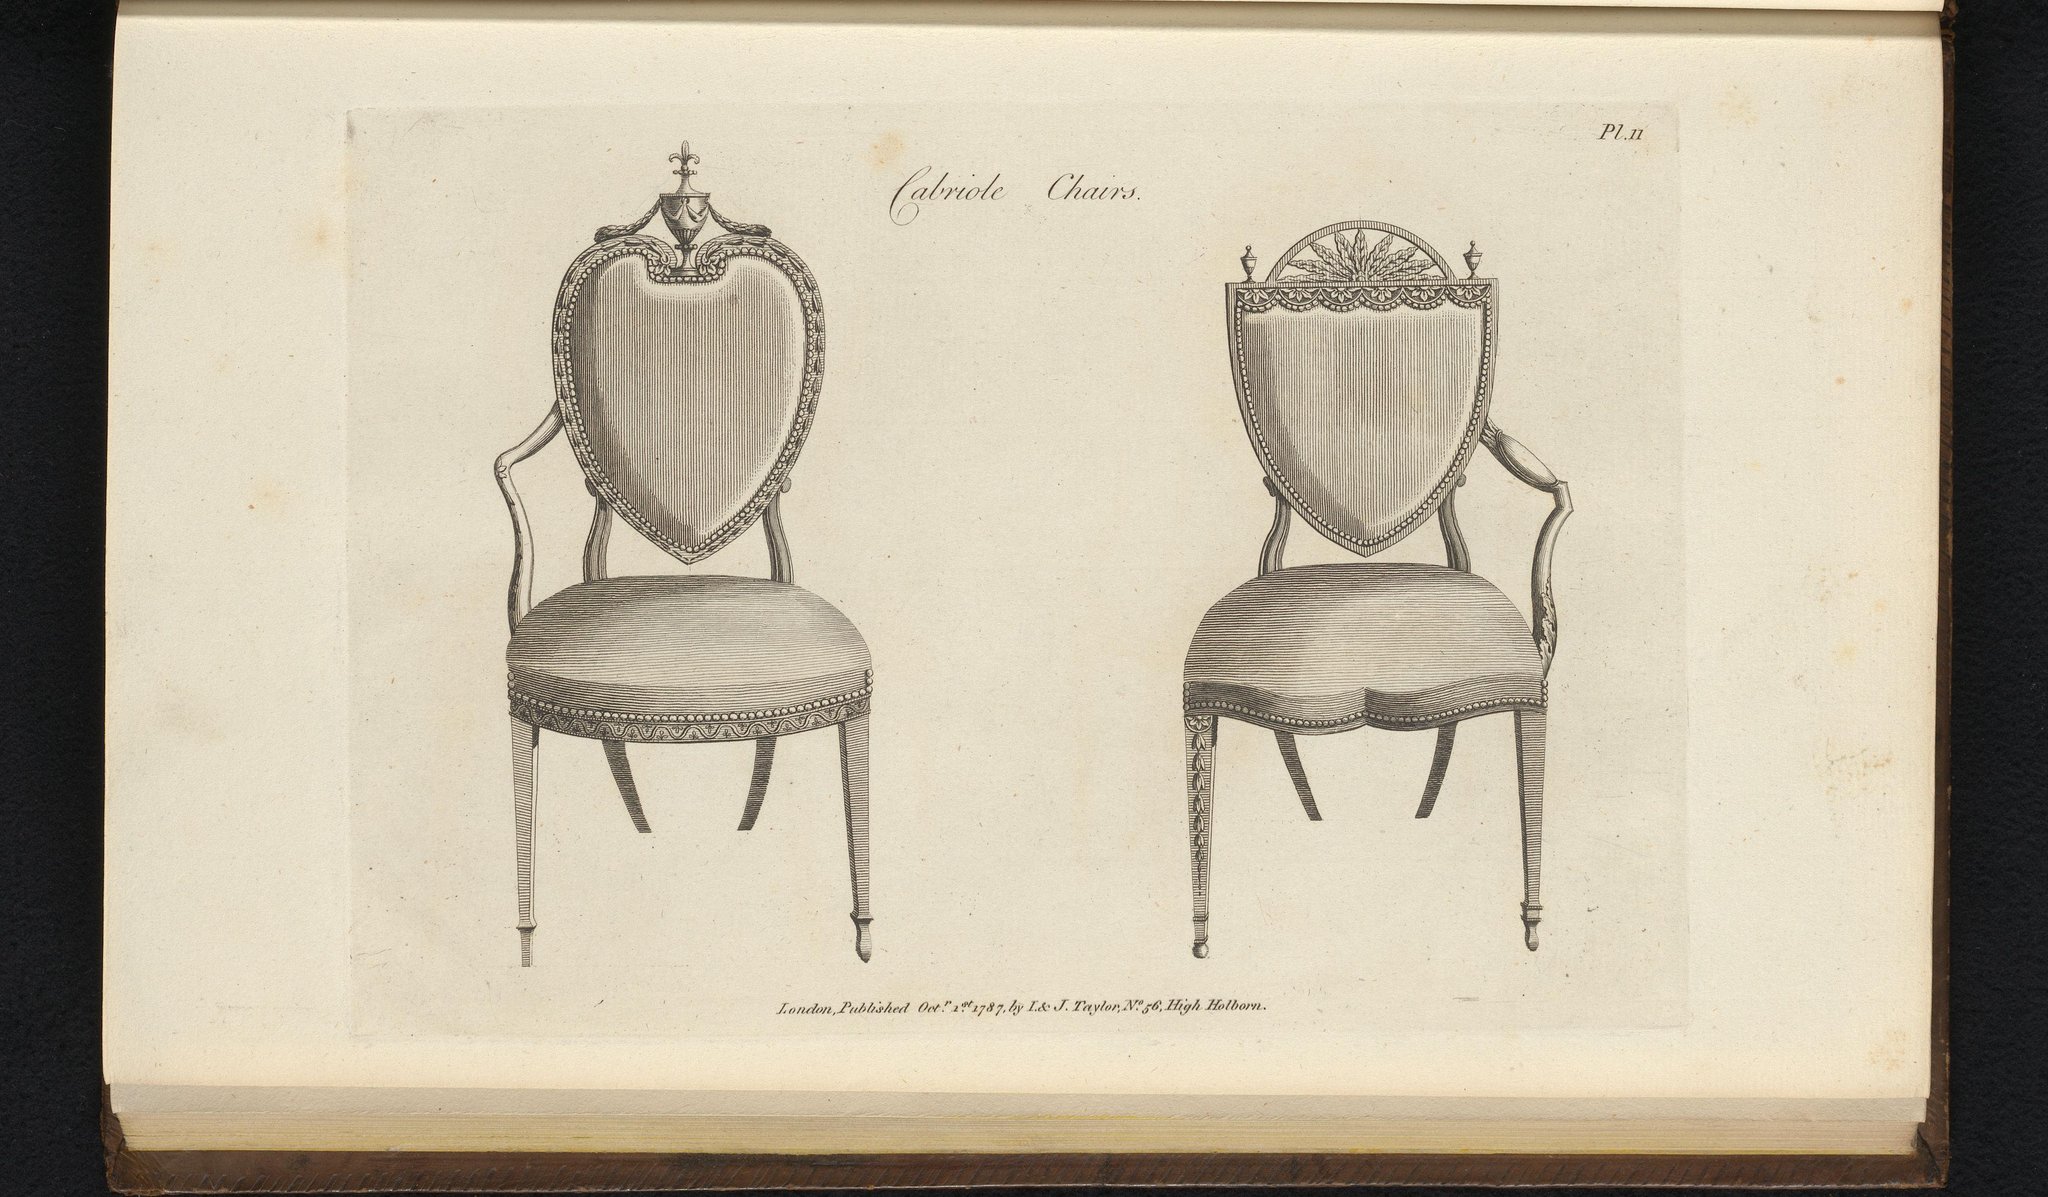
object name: print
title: Twee stoelen met verschillende ornamenten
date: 1787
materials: paper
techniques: engraving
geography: holborn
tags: chair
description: Genummerd: Pl. 11. Prent maakt deel uit van een boek.